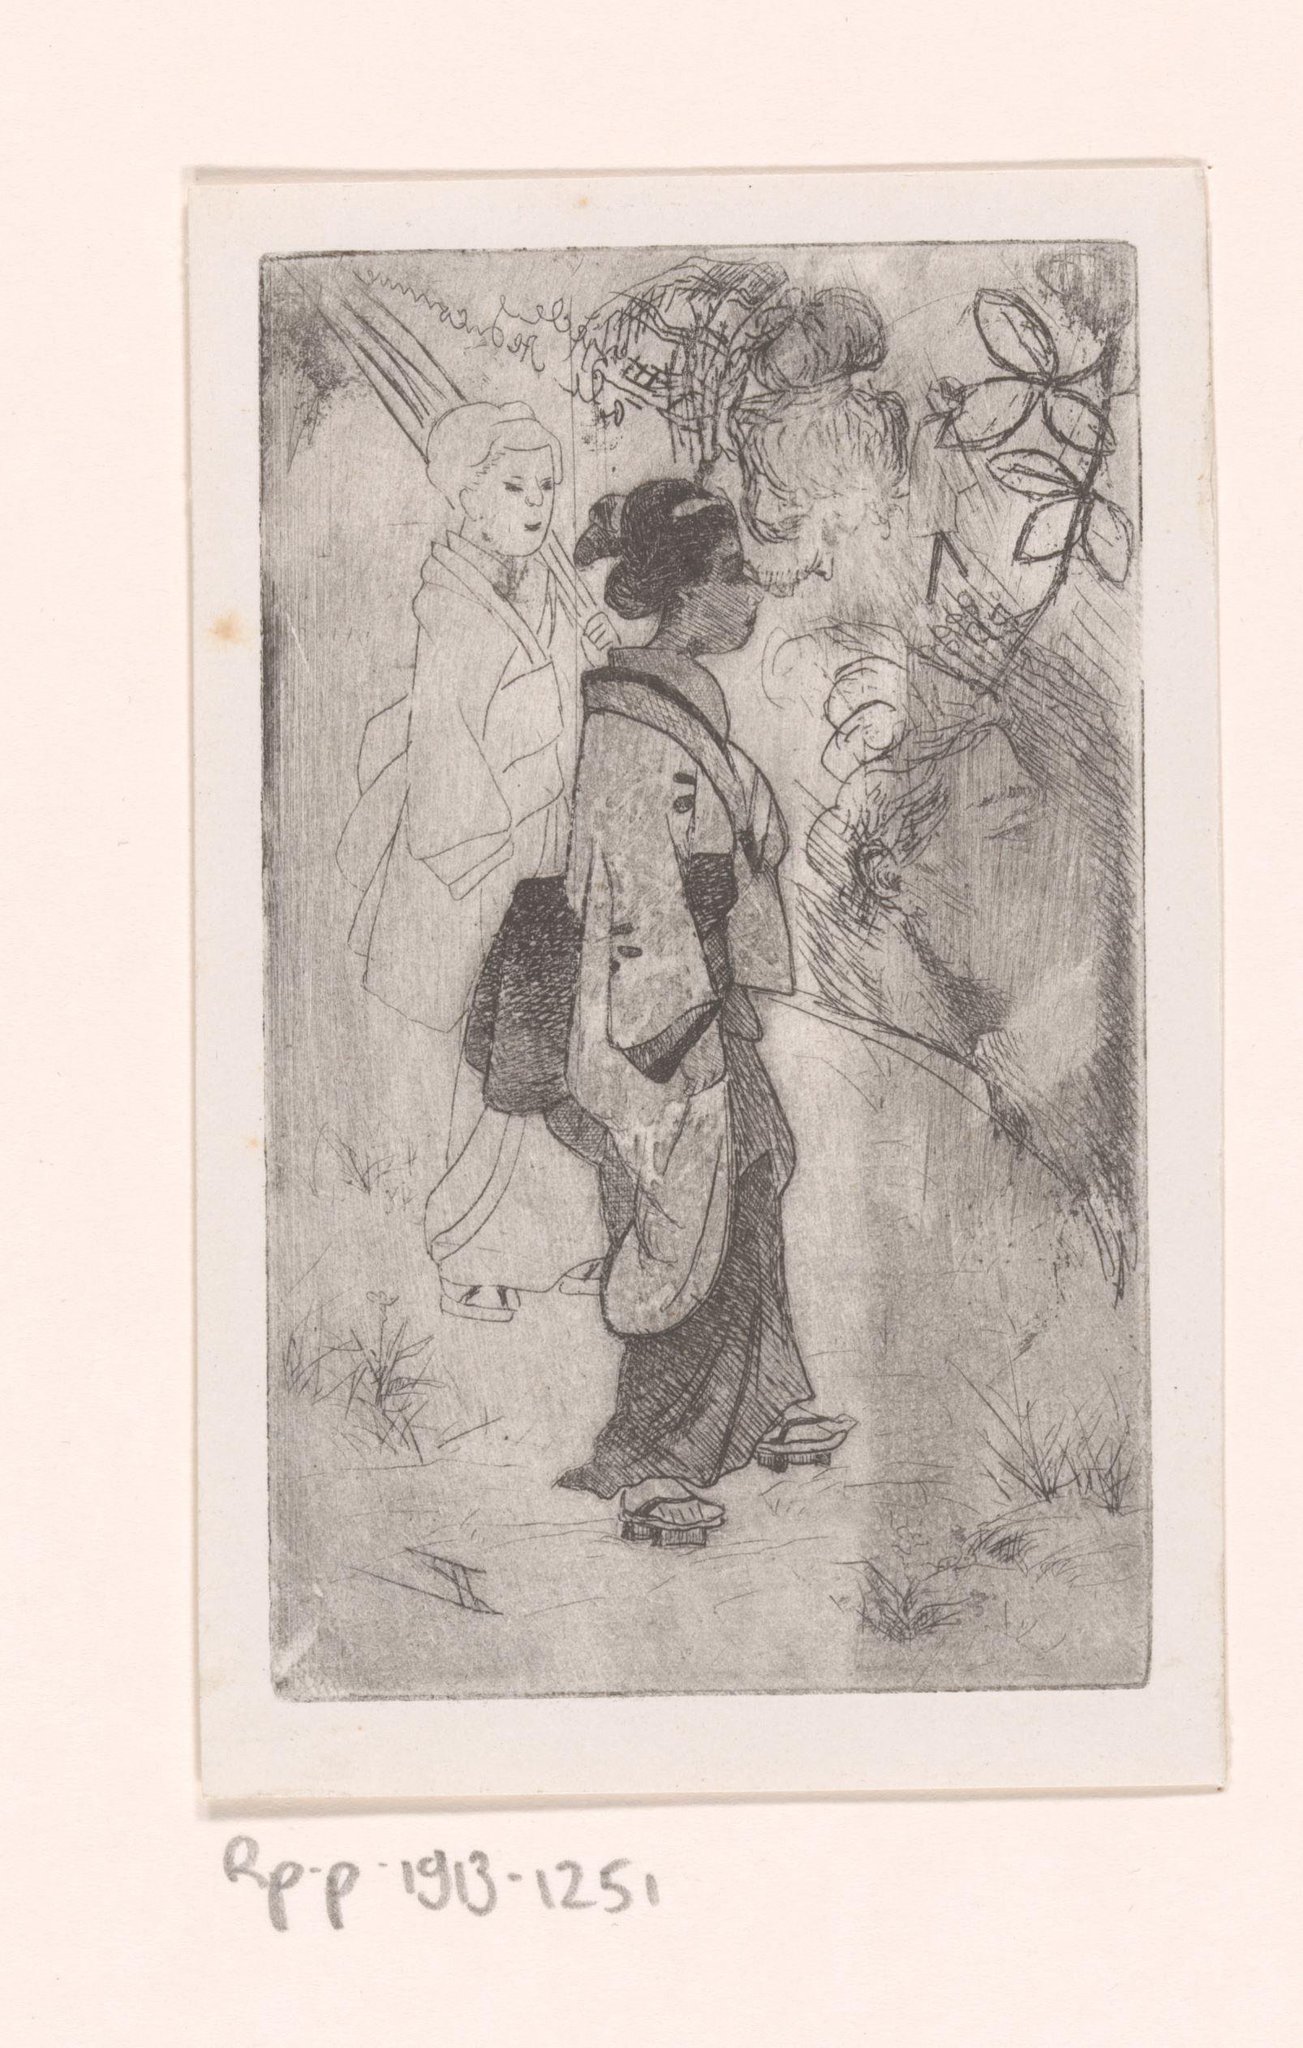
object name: print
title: Japanse vrouwen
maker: philip zilcken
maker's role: draughtsman, painter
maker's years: 1857-1930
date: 1867-1890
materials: paper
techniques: etching, intaglio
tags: female sex; woman, japanese (+ costume)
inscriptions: collector's mark: Lugt 2233